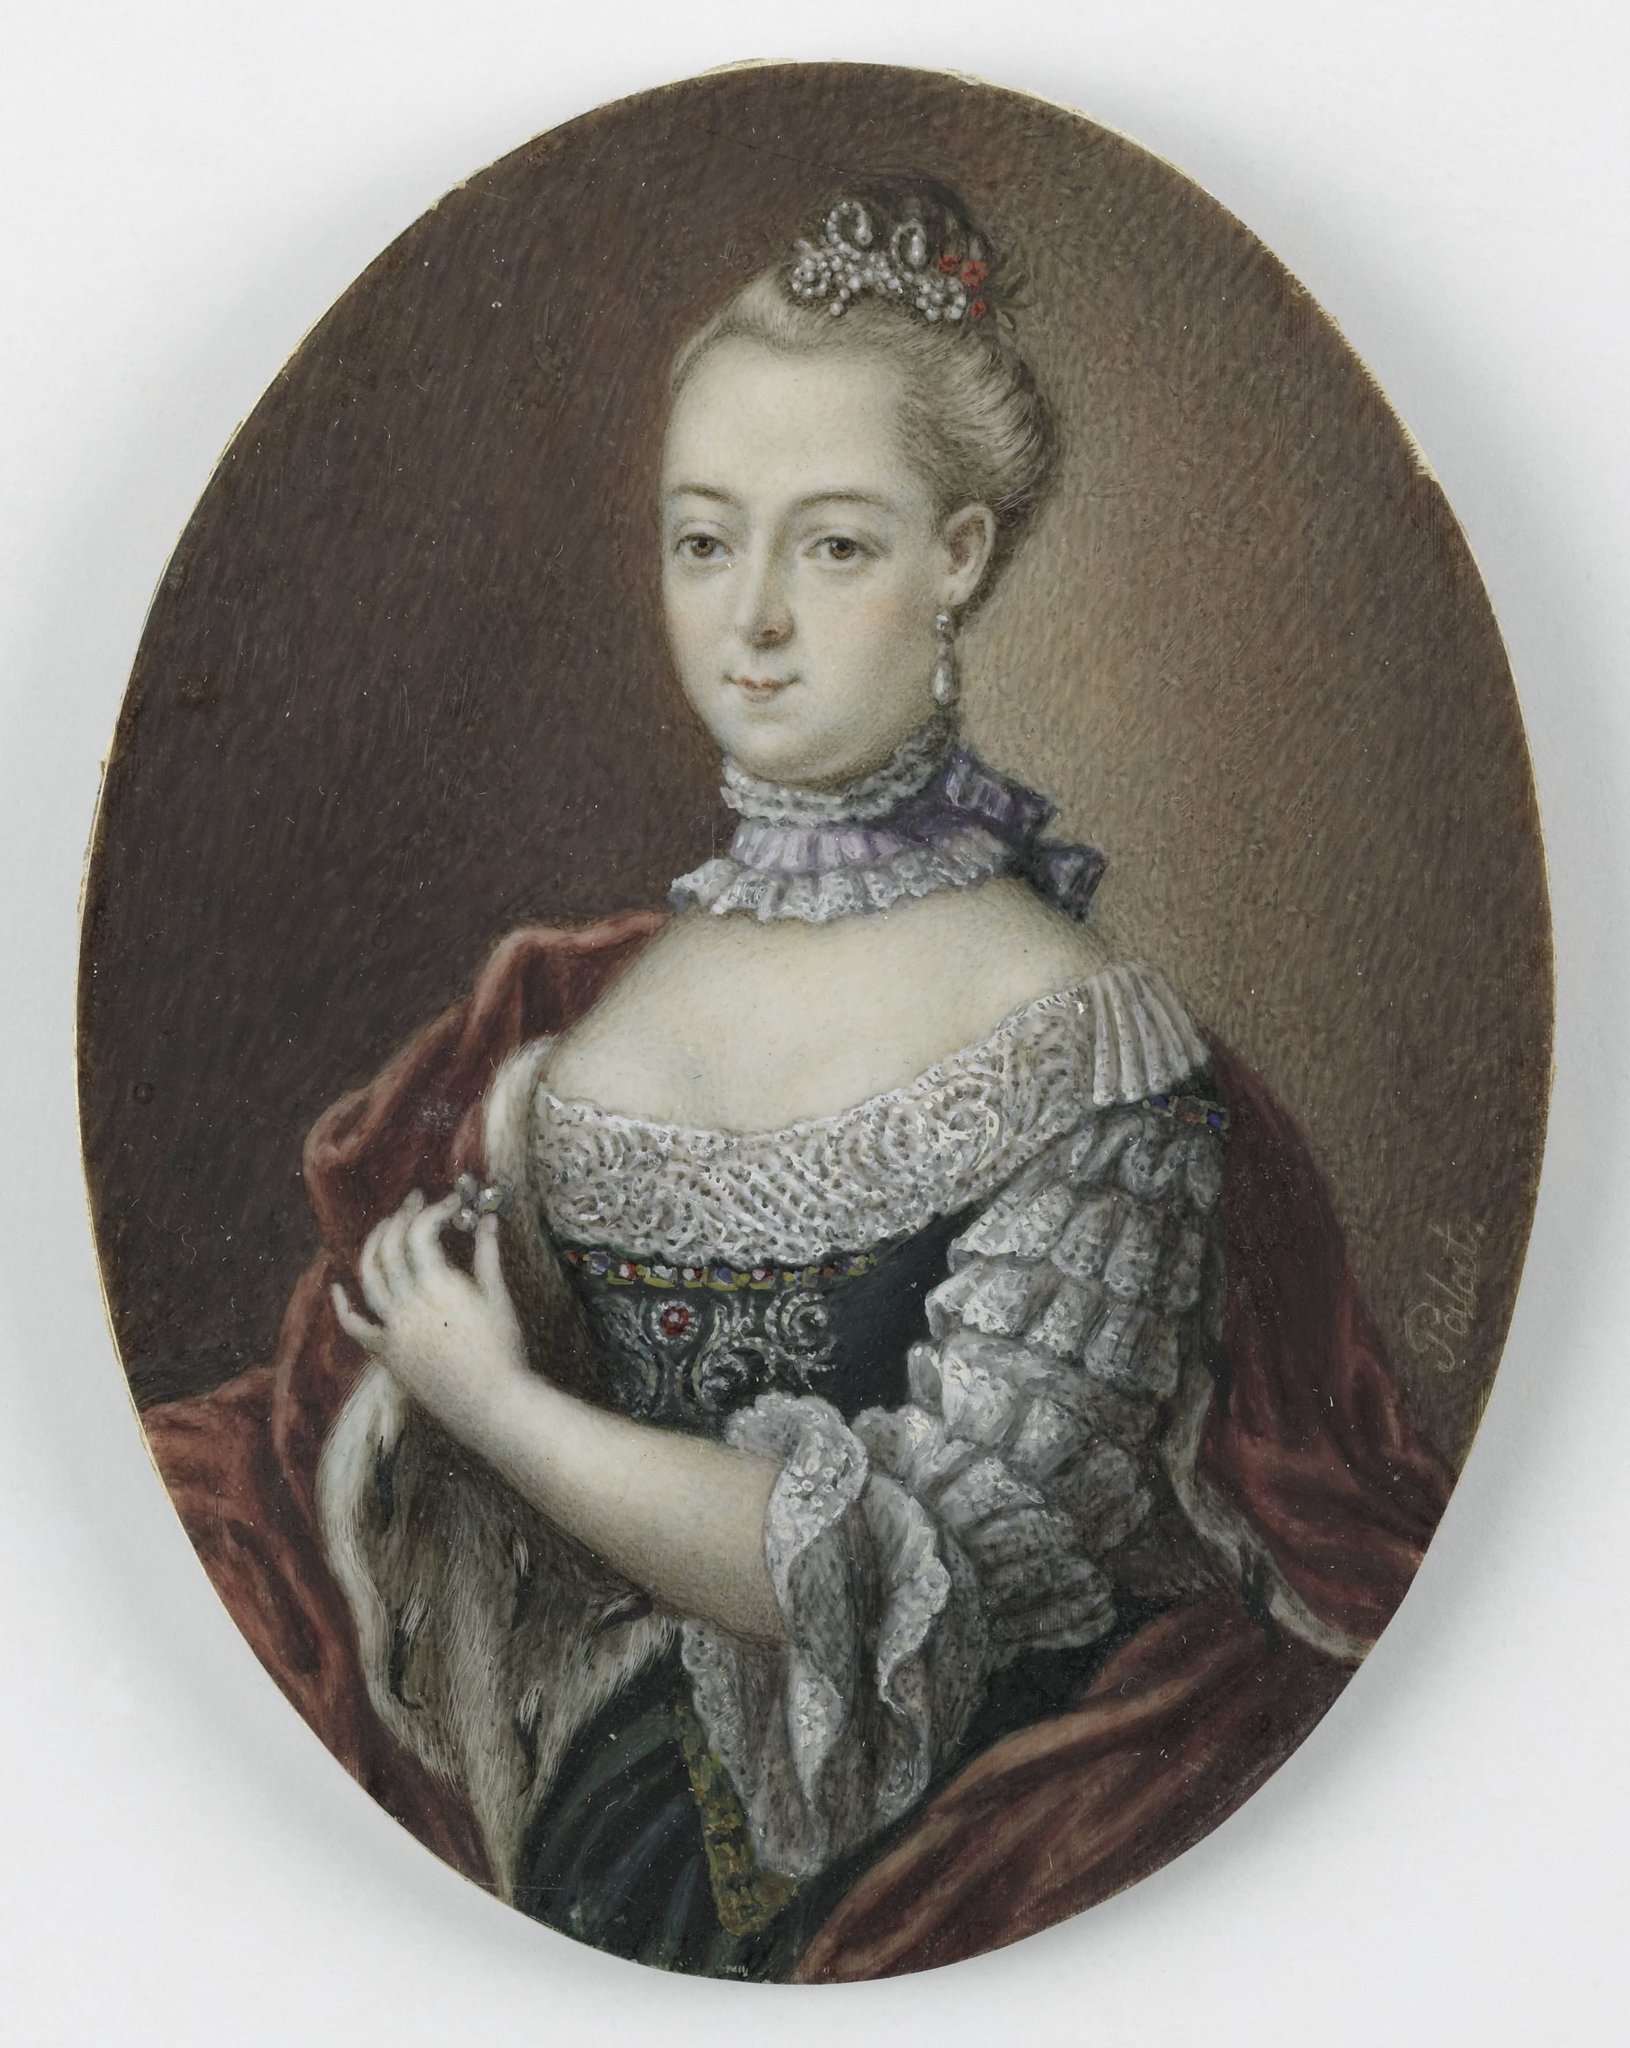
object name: painting, miniature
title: Frederica Carolina van Brandenburg (1735-91). Dochter van hertog Franz Josias van Saksen Coburg Saalfeld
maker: Anonymous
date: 1755-1799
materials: glass, ivory, metal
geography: germany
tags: frederica carolina van brandenburg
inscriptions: inscription: ‘Palats’, inscription: ‘Frederica Carolina March. Brandenb. N.d. 24 Juni 1735’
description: Portret van Frederica Carolina van Brandenburg (1735-91). Dochter van hertog Franz Josias van Saksen Coburg Saalfeld. Ten halven lijve, naar links. In de linkerhand een sieraad van drie parels. Onderdeel van de collectie portretminiaturen.